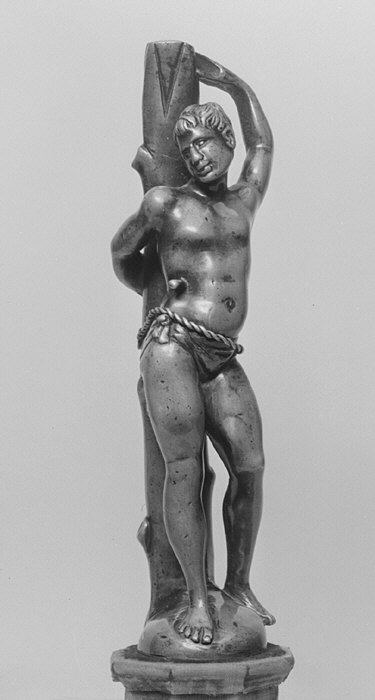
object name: statuette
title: Saint Sebastian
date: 1567-1600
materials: brass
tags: men,saints